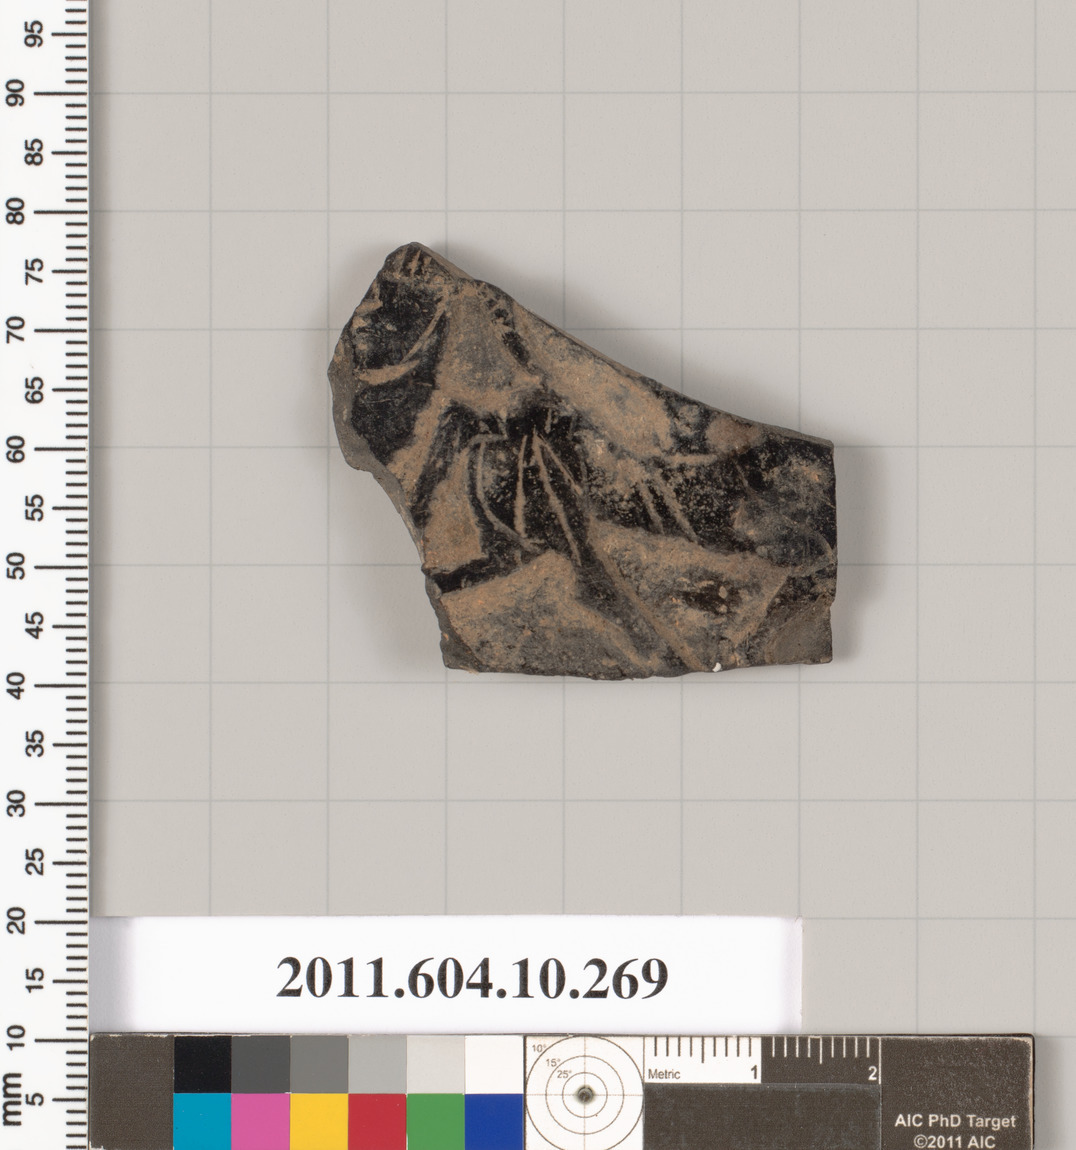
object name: undetermined shape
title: Terracotta fragment of an undetermined shape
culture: etruscan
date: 600-501 BCE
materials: terracotta